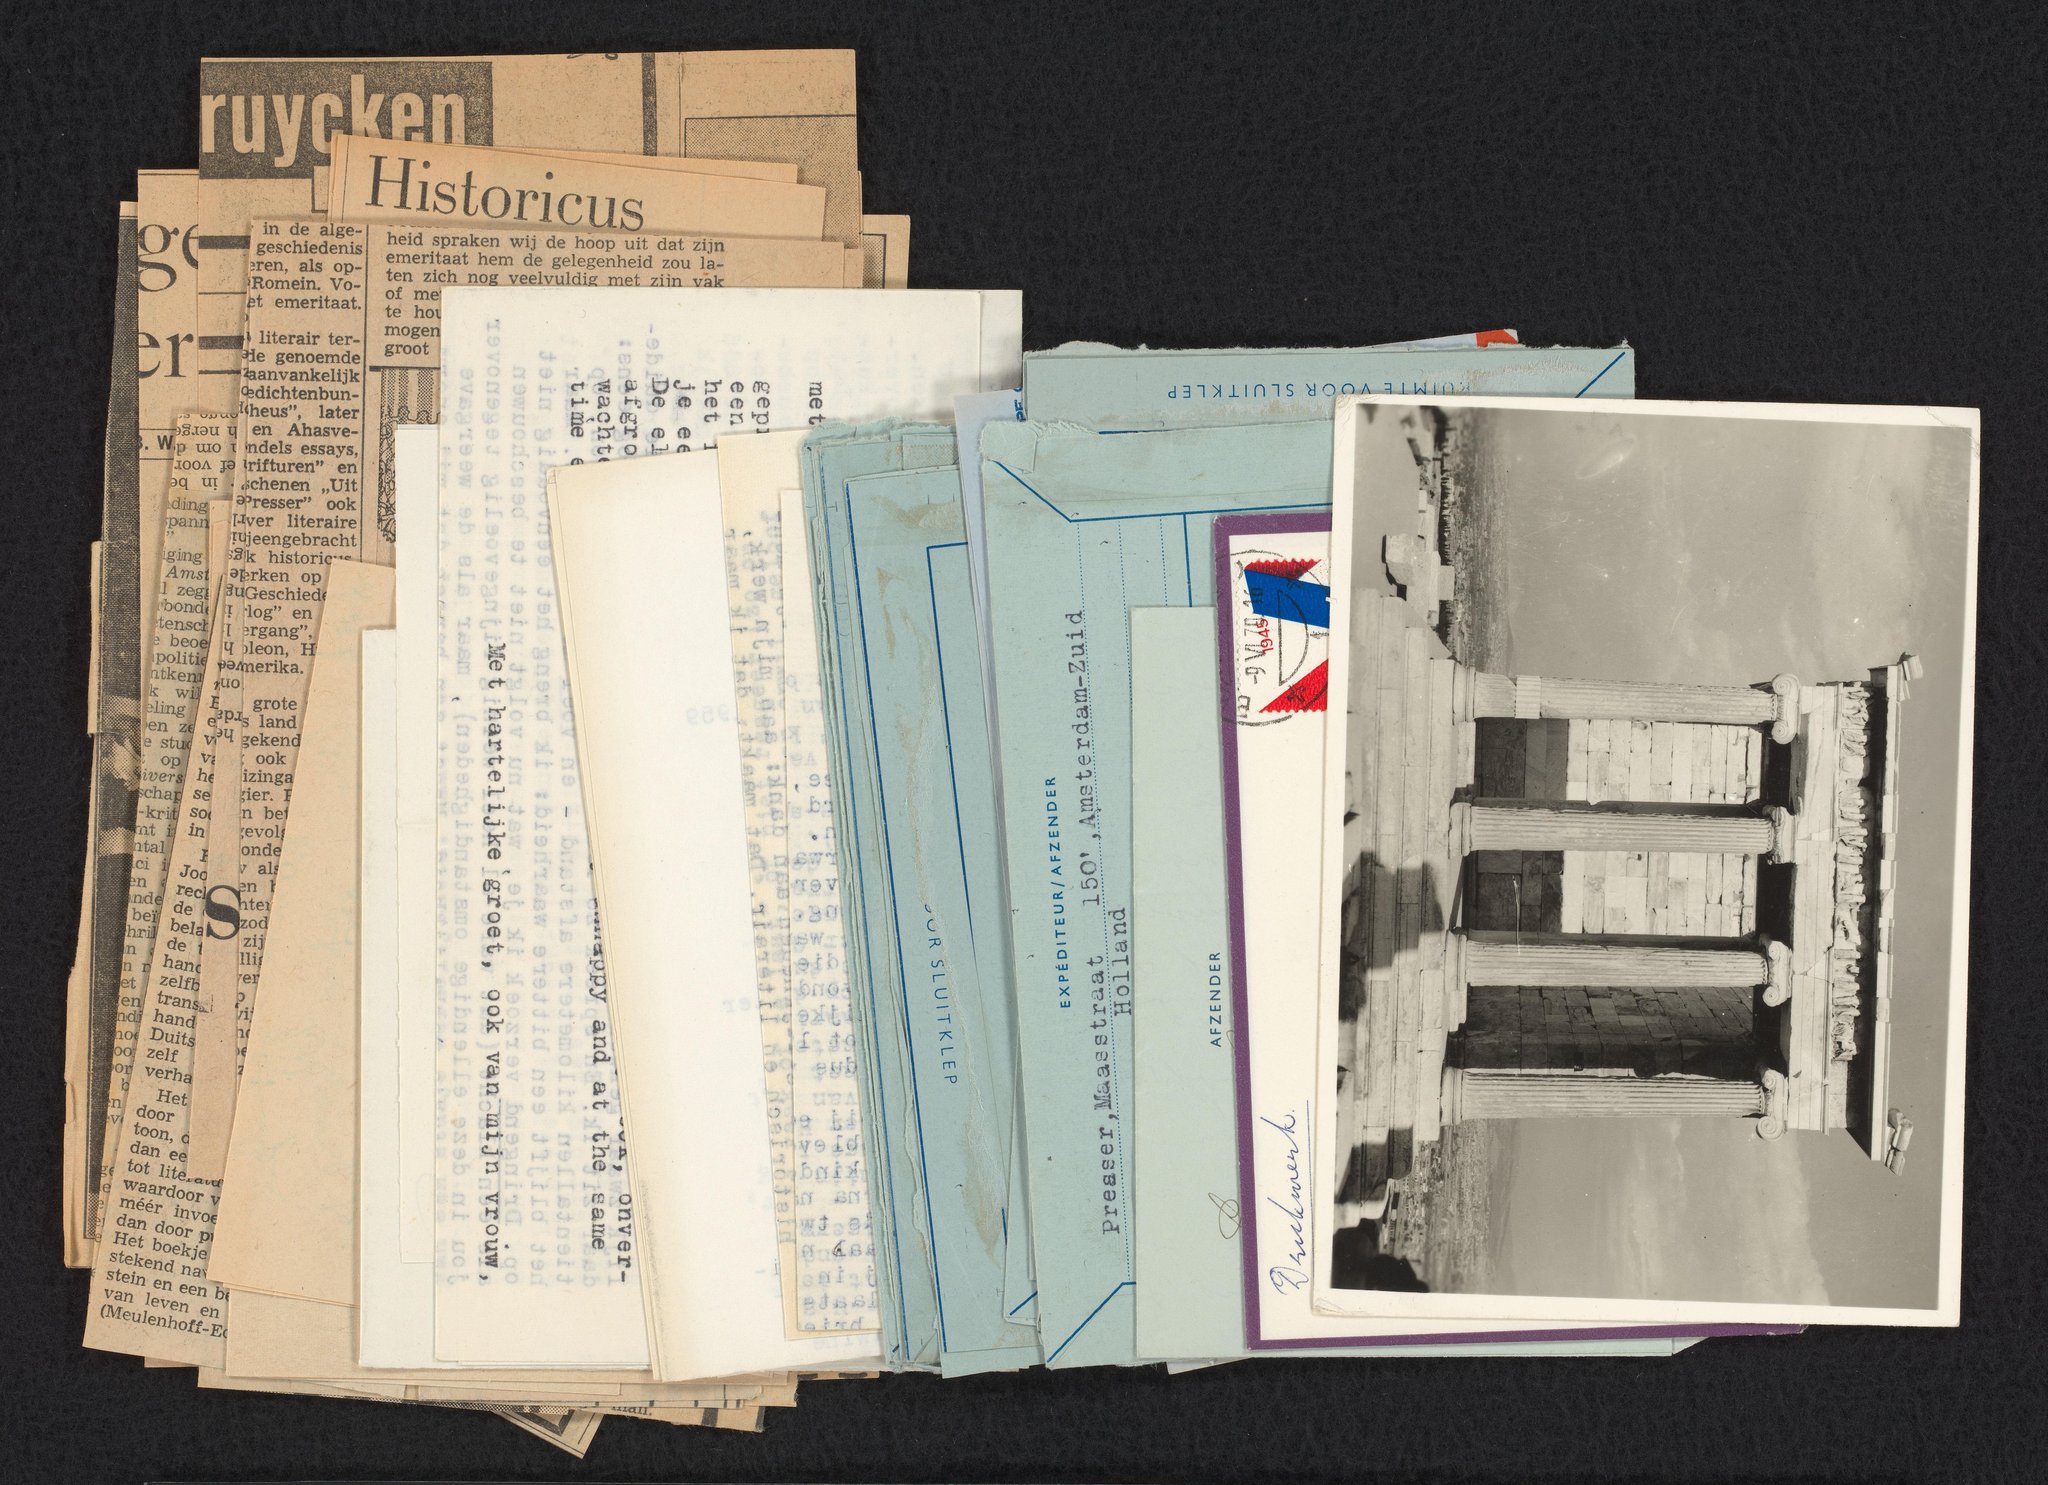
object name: newspaper clipping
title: Correspondentie tussen Jacques Presser en Isabel Wachenheimer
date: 1953-1970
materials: paper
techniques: handwriting, typewriting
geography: netherlands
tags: amsterdam, jacques presser, leiden, isabel wachenheimer-elon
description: Dit object is onderdeel van de nalatenschap van Isabel Elon-Wachenheimer (1928-2010). Tot haar overlijden behoorde het samen met de andere objecten uit de nalatenschap tot haar privédomein van Isabel Wachenheimer. In die particuliere context zijn deze objecten tezamen en individueel aandenkens - aan de jeugd, ouders en familie van Isabel Wachenheimer vóór en tijdens de Shoah en aan haar leven na de Tweede Wereldoorlog. Isabel Wachenheimer, die van juni 1943 tot mei 1945 gevangen zat in Kamp Westerbork, Theresienstadt, Auschwitz, Lenzing a/d Oberdonau (een buitenkamp van Mauthausen), overleefde de Shoah. Haar ouders – Eugène Wachenheimer en Else Wachenheimer-Moos - werden op 14 oktober 1944 in Auschwitz-Birkenau vermoord.